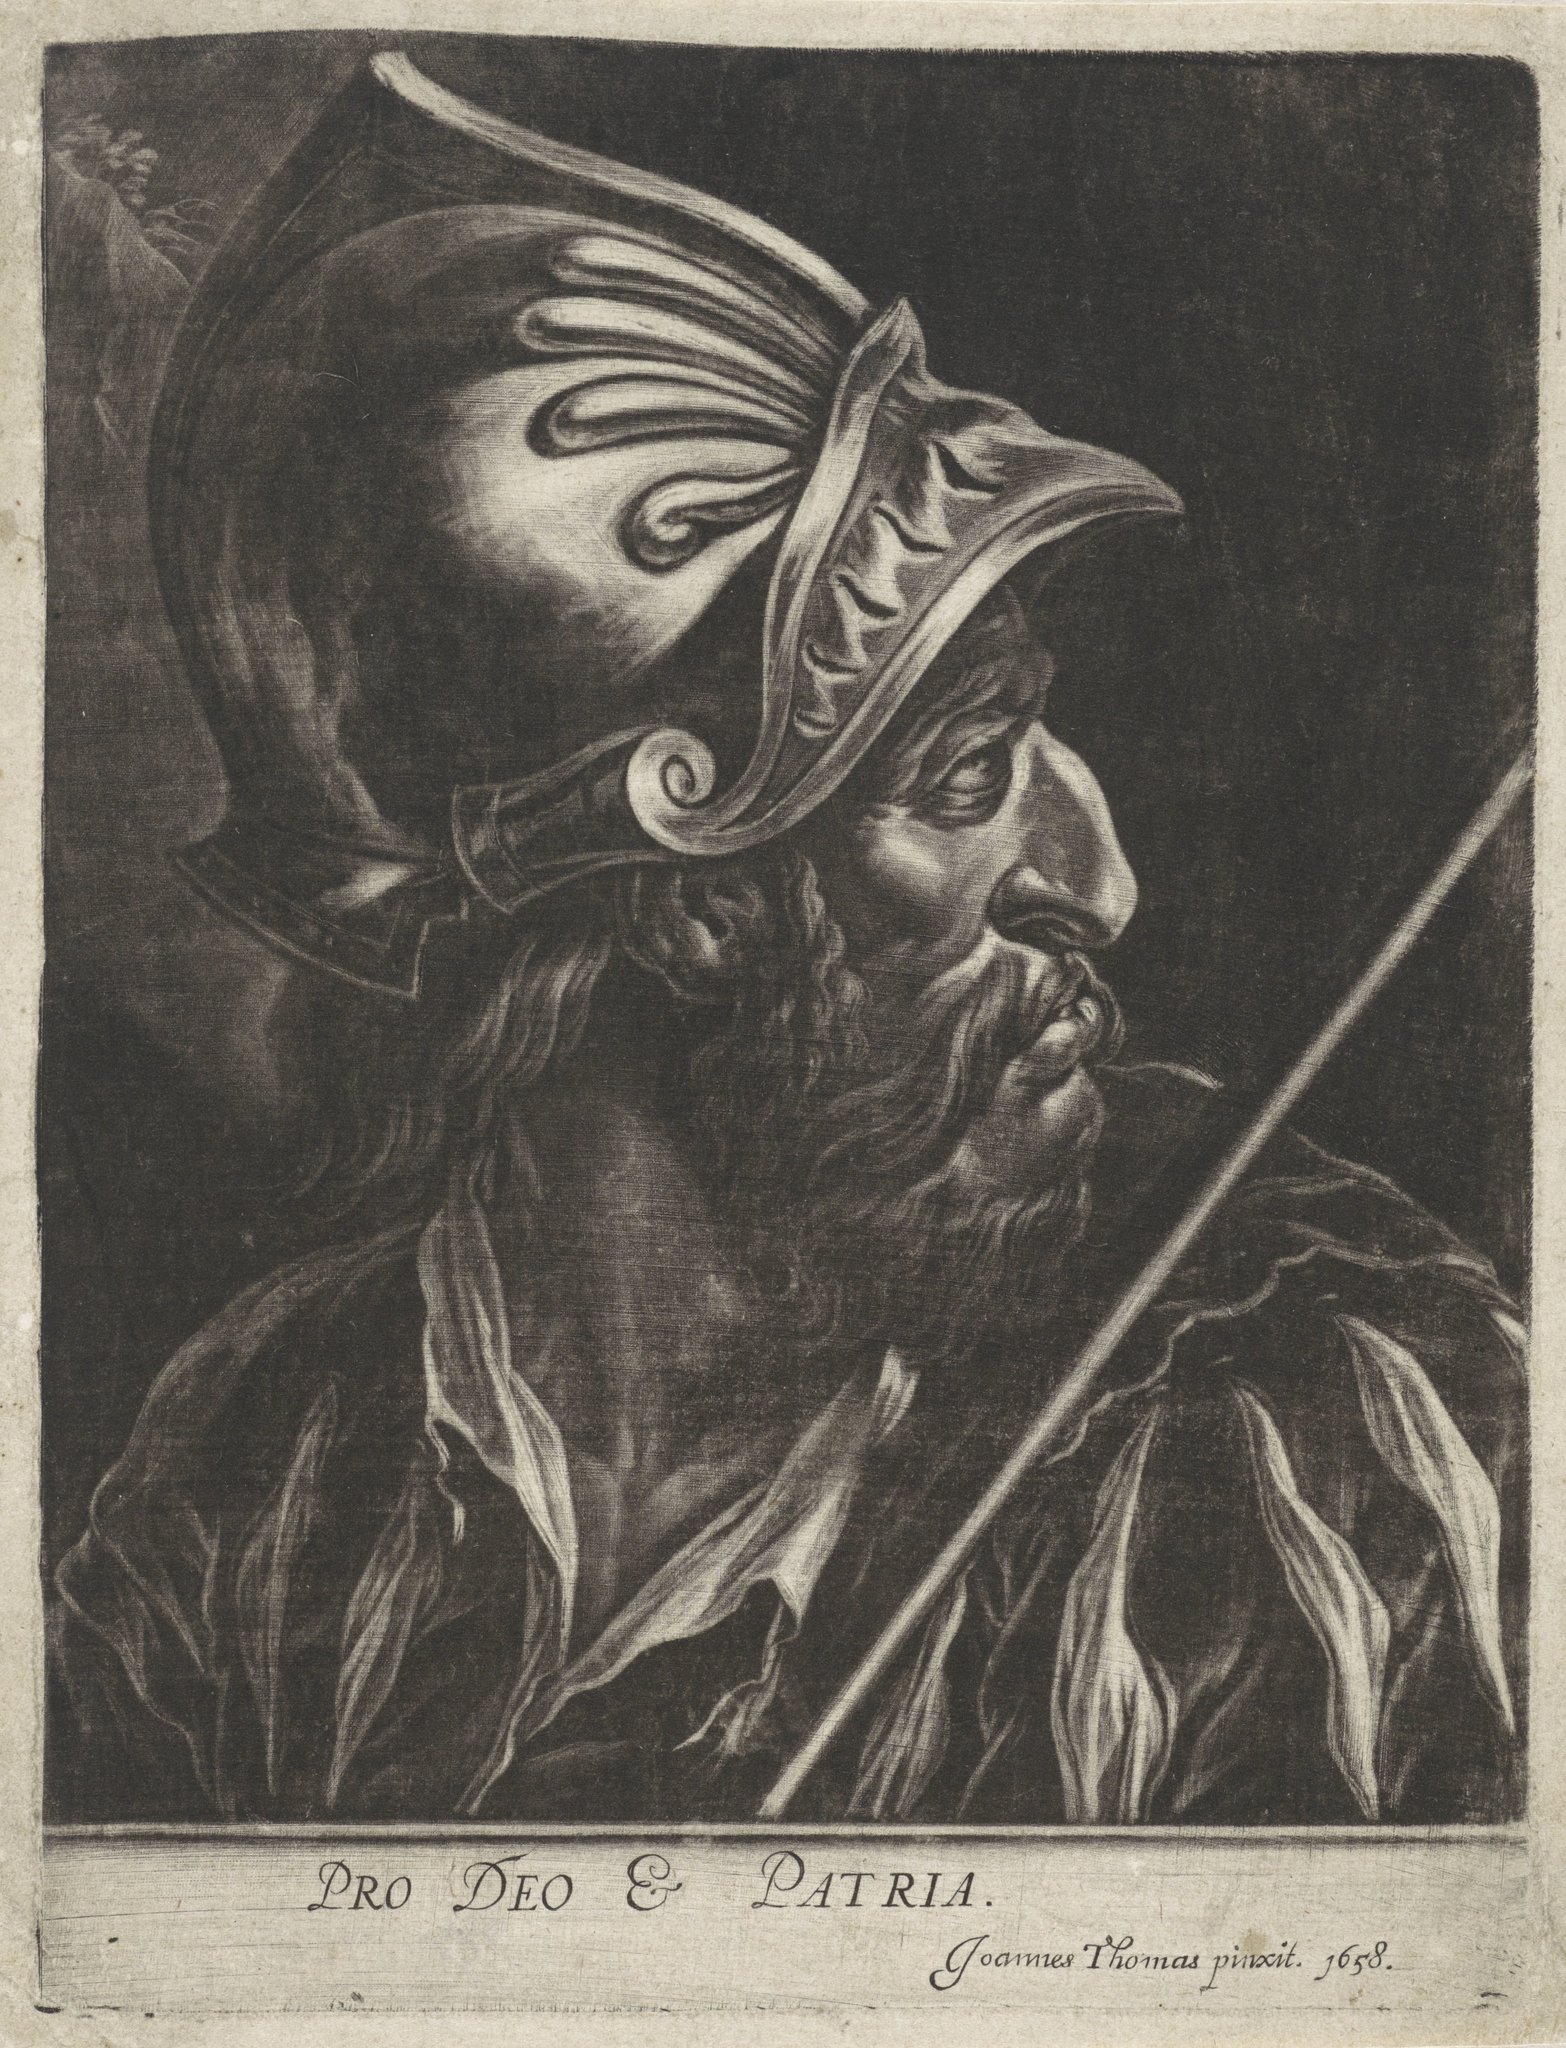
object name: print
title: Pro Deo & Patria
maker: jan thomas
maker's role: print maker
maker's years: 1617-1678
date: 1658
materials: paper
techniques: mezzotint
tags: helmet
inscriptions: collector's mark: Lugt 2228